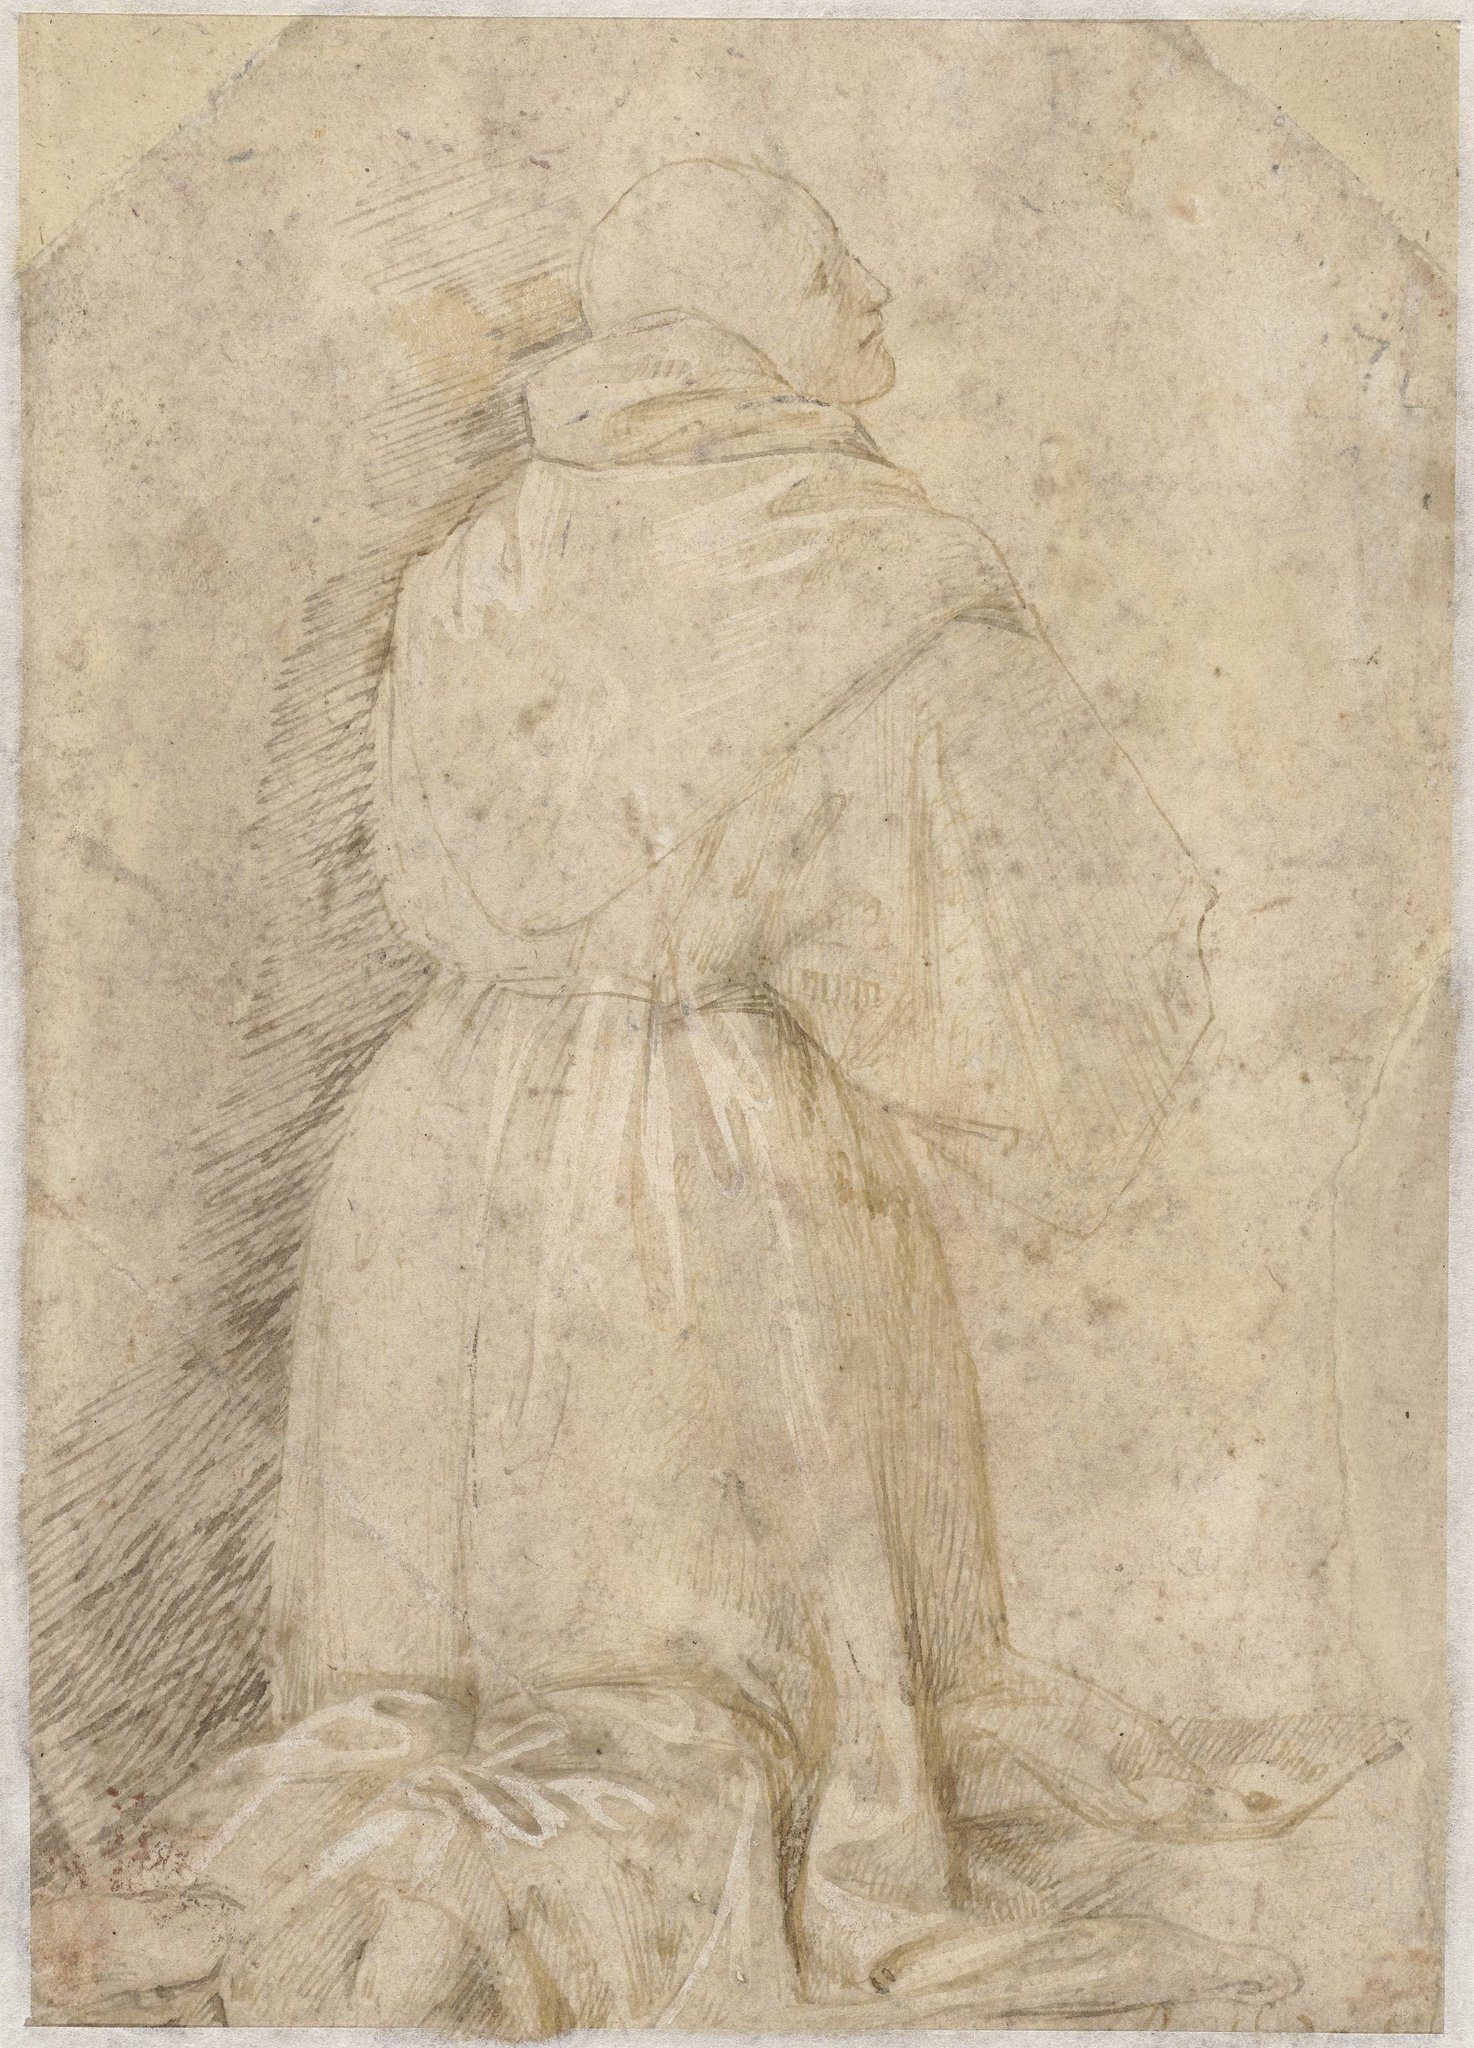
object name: drawing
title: Knielende monnik, op de rug gezien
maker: domenico ghirlandaio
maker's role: draughtsman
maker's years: 1449-1494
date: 1460-1494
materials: ink, paper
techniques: brush, pen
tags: monk(s), friar(s)